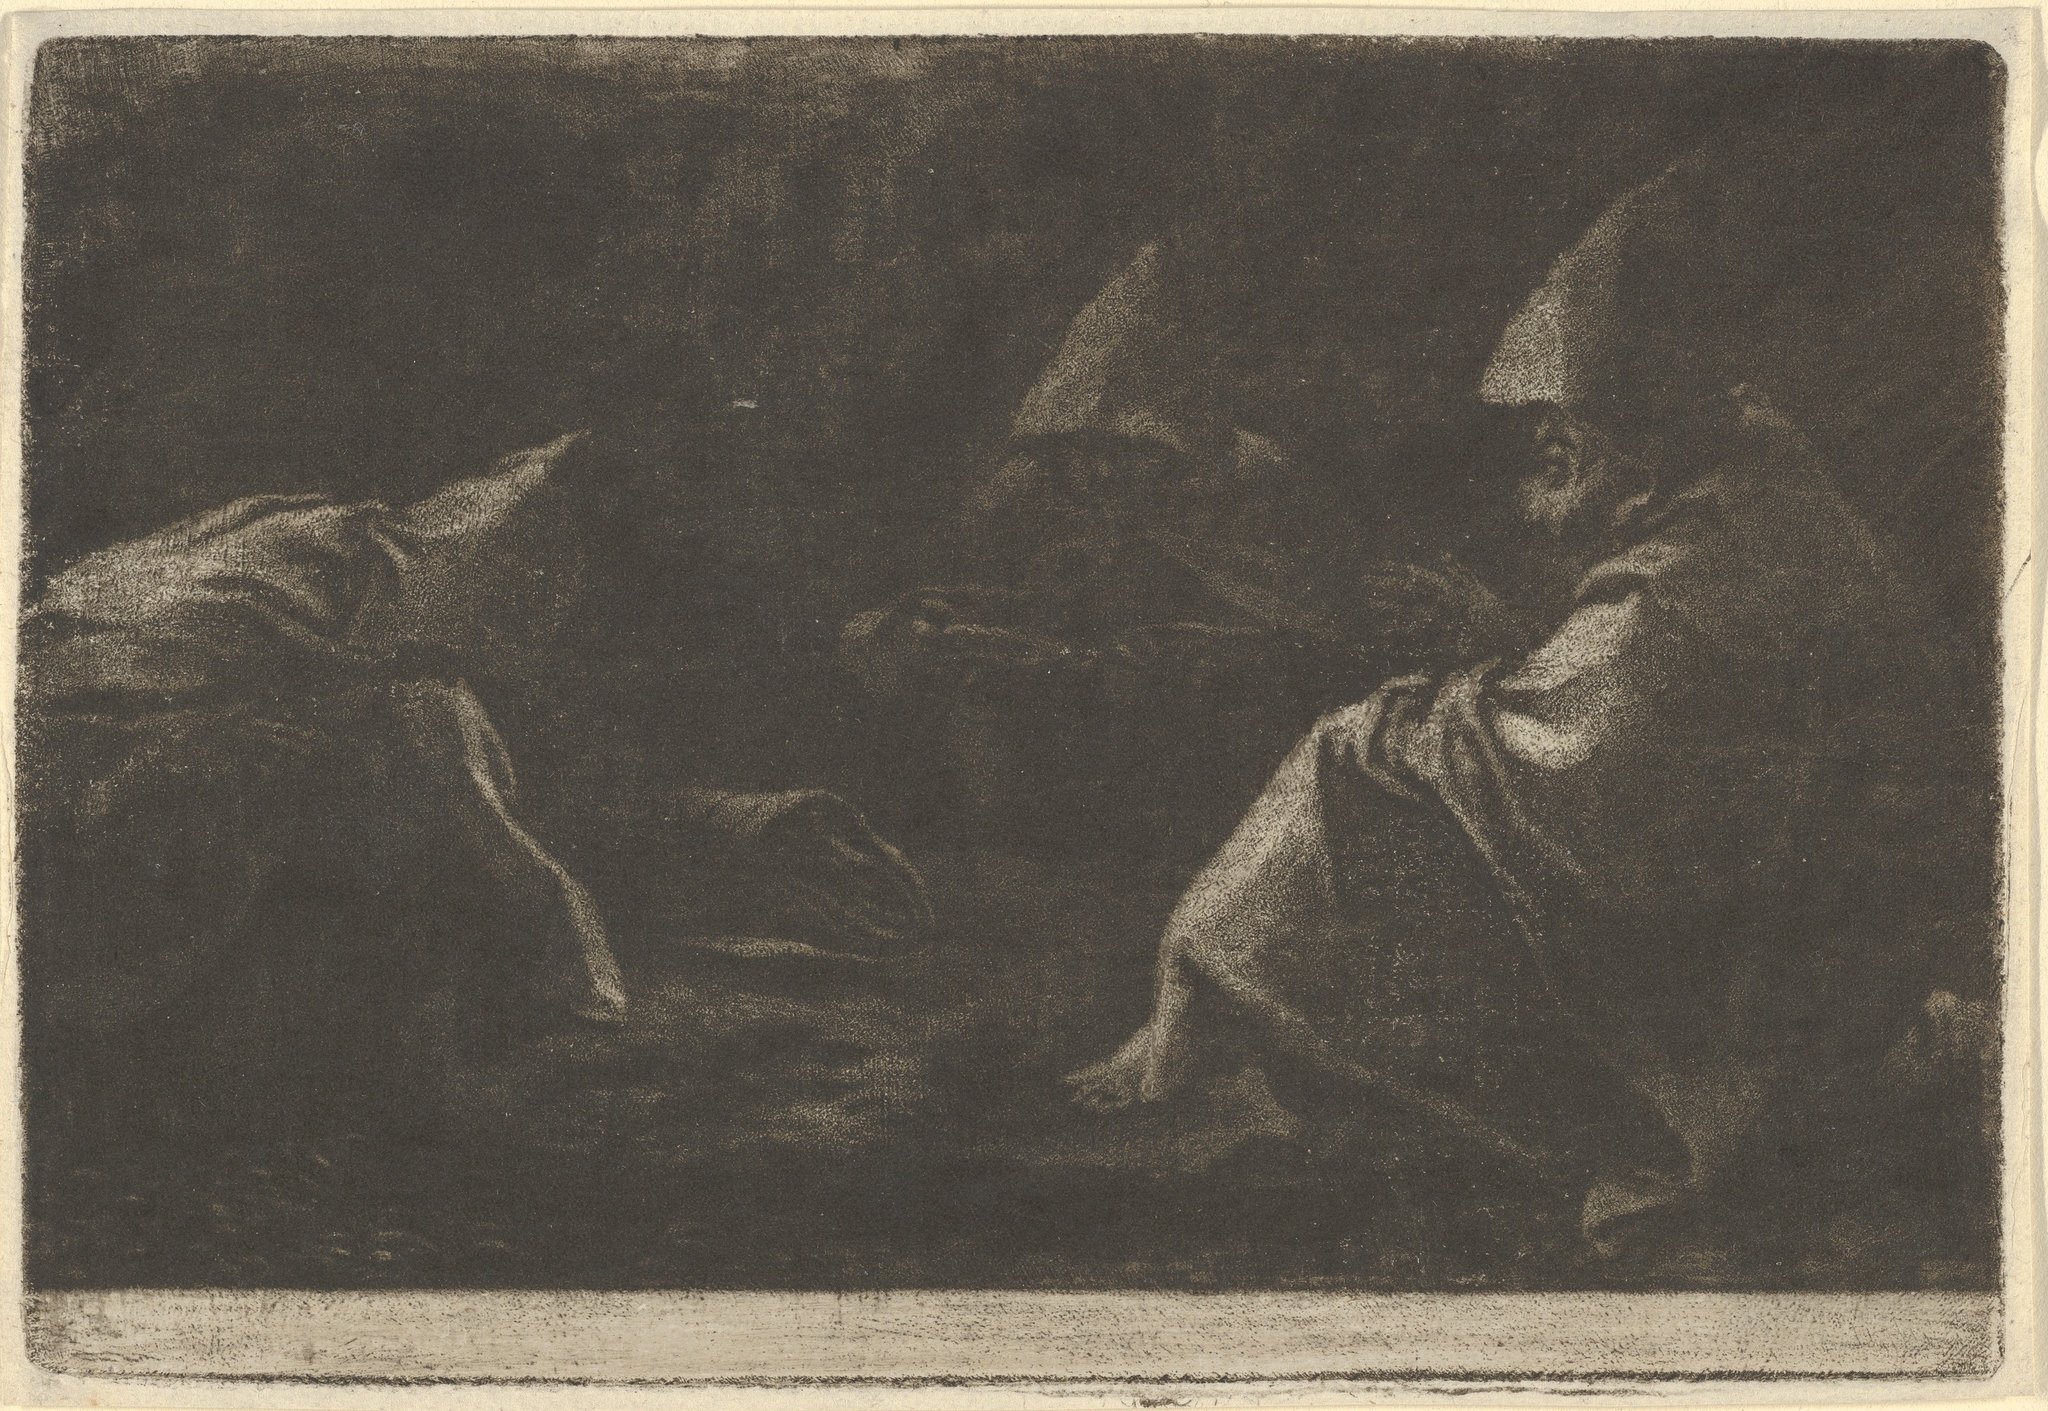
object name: print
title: Three Capuchins Seated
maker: allart van everdingen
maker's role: artist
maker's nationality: dutch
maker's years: 1621-1675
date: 1621-1675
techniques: mezzotint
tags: men